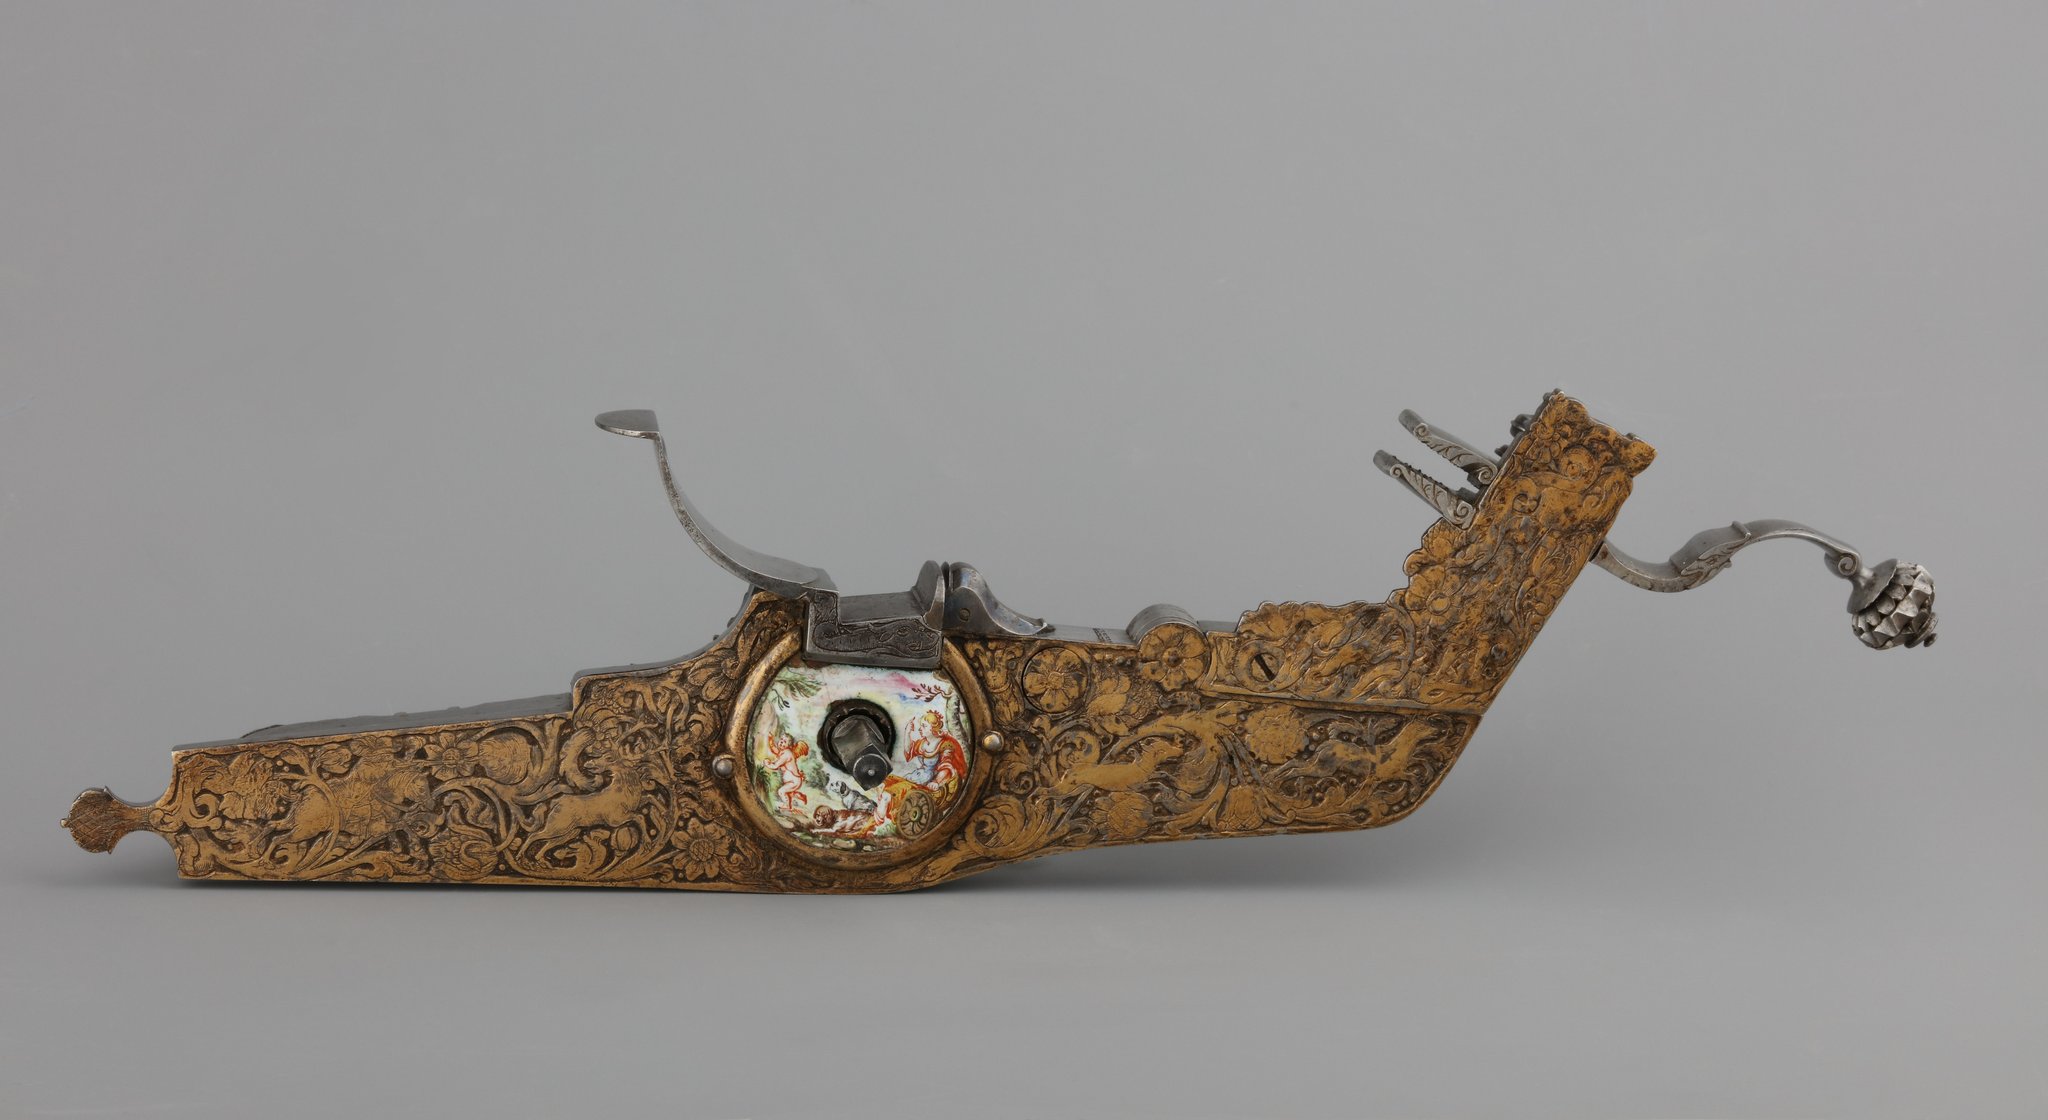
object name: wheellock rifle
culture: german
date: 1701-1733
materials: enamel, gold, steel, wood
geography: germany